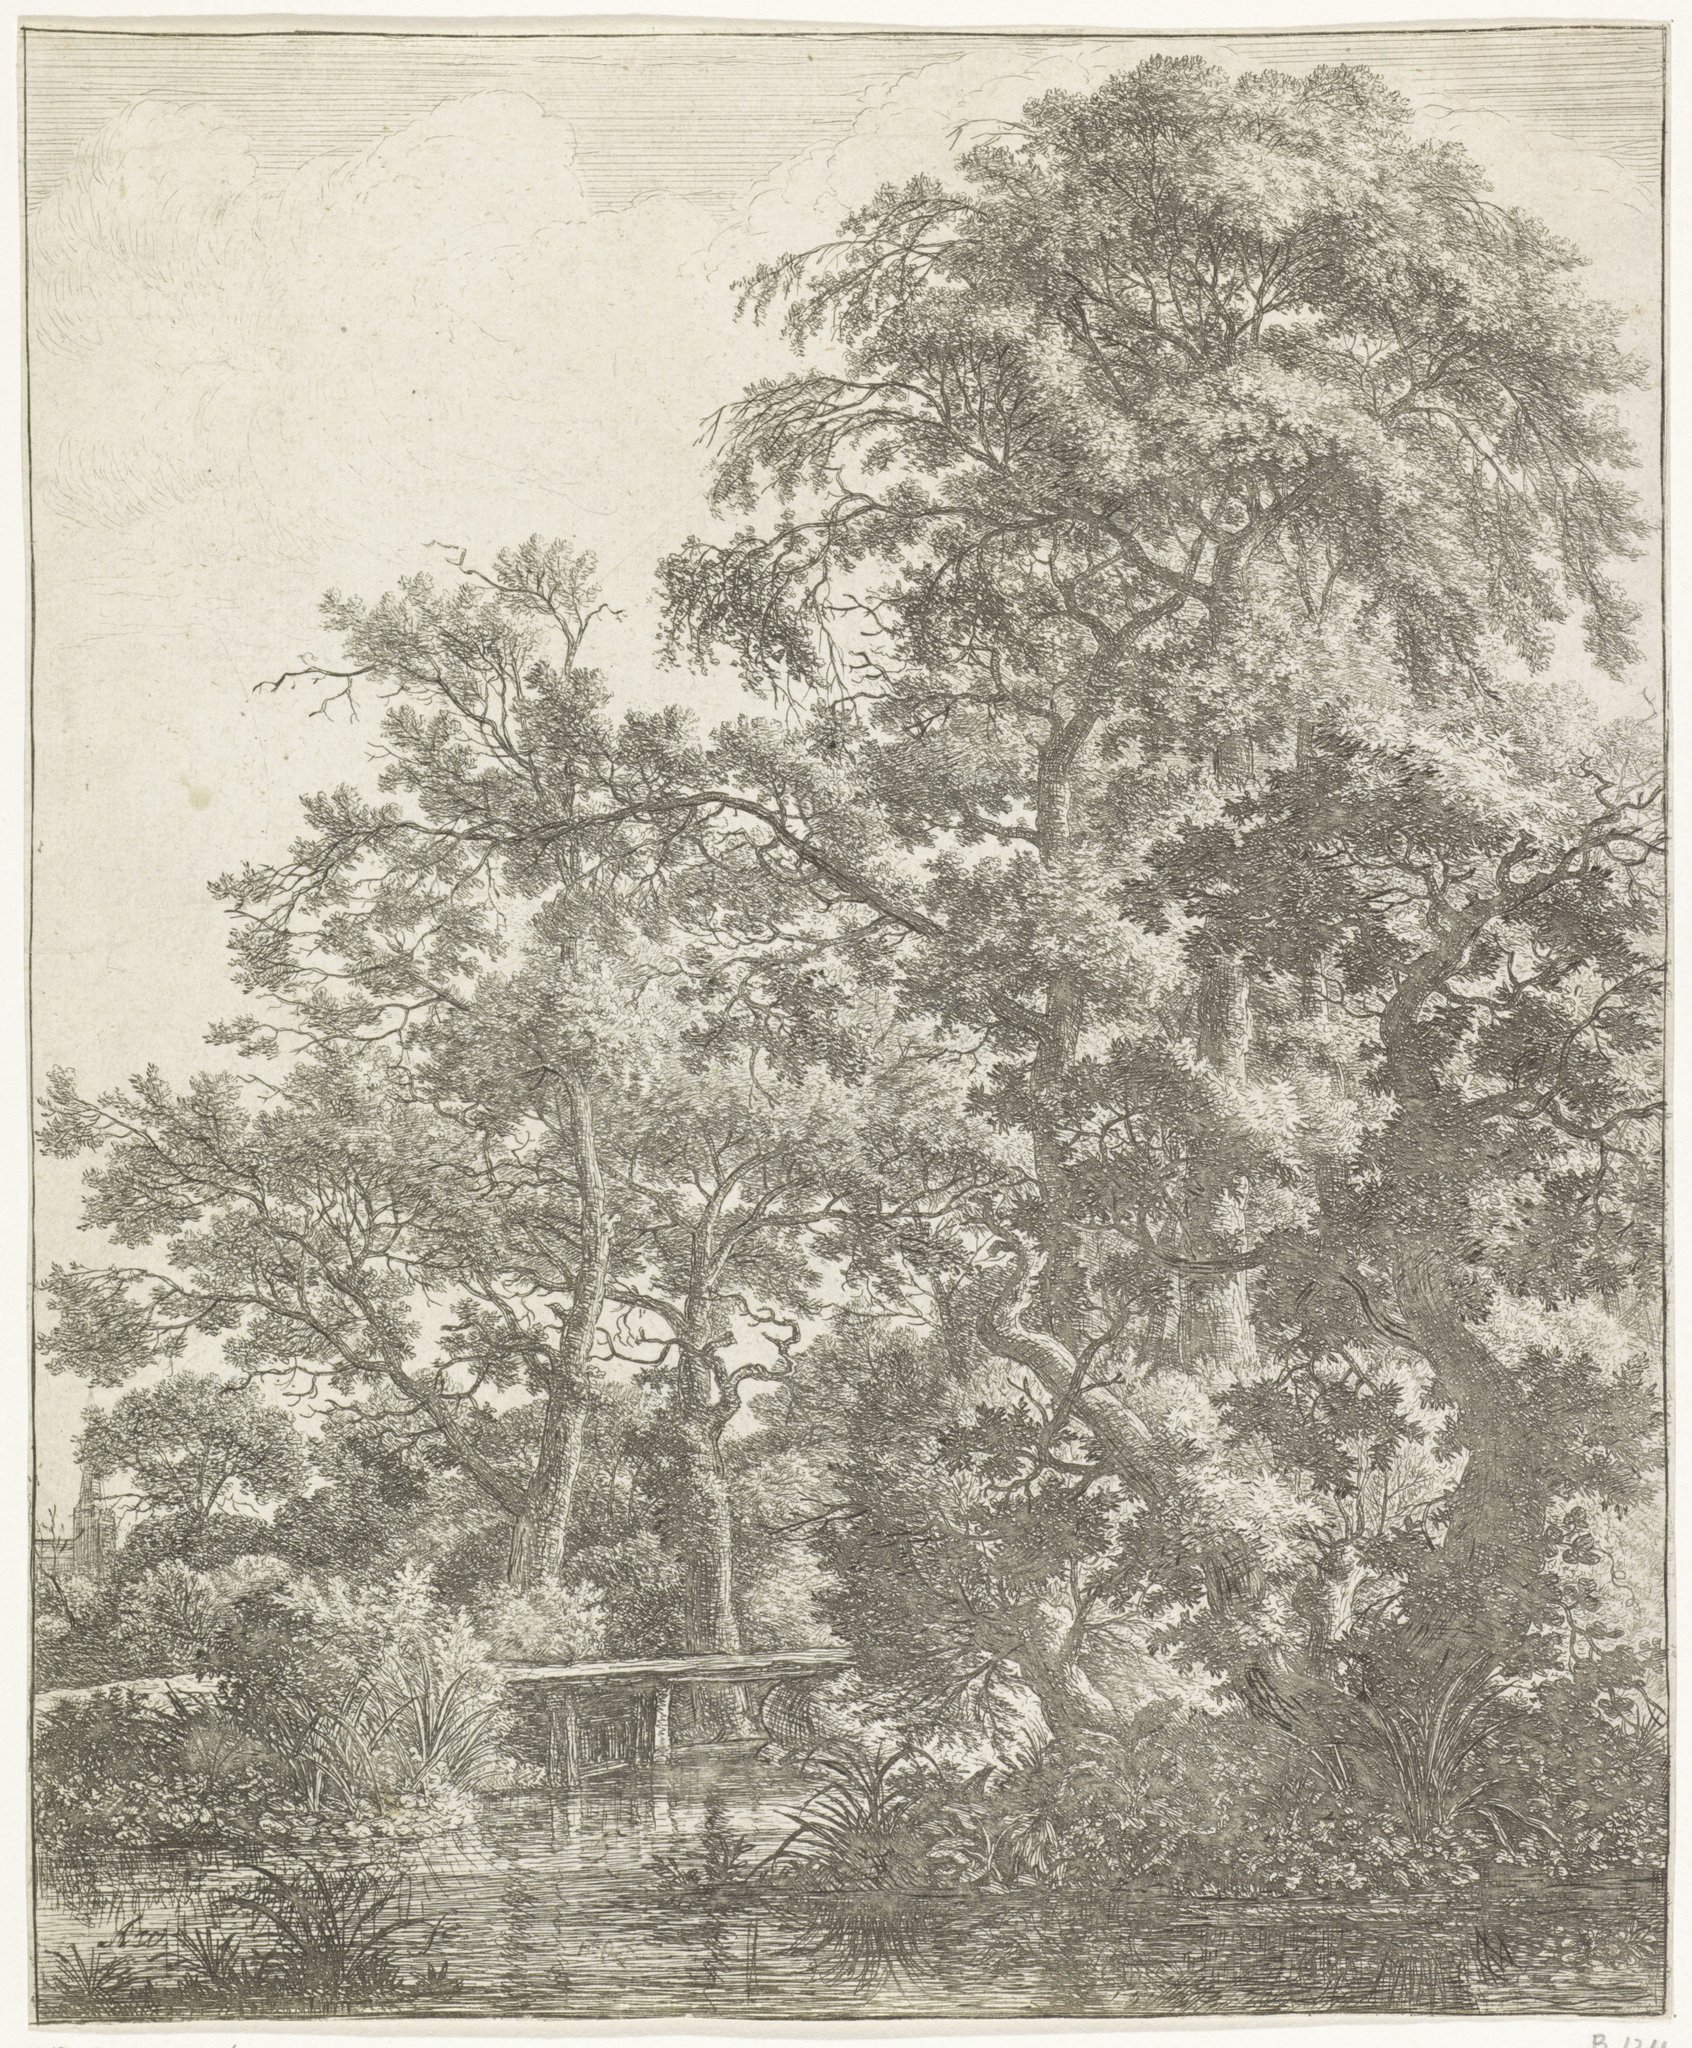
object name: print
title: Smalle brug over een beek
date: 1630-1663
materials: paper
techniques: etching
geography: amsterdam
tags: forest, wood, brook, bridge, parts of church exterior and annexes: tower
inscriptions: collector's mark: Lugt 2228, inscription: ‘Late versleten druk 18e eeuw’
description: In een bosrijke omgeving is een smalle, houten brug weergegeven. Onder de brug loopt een beek. Links in de verte is een kerktoren te zien.